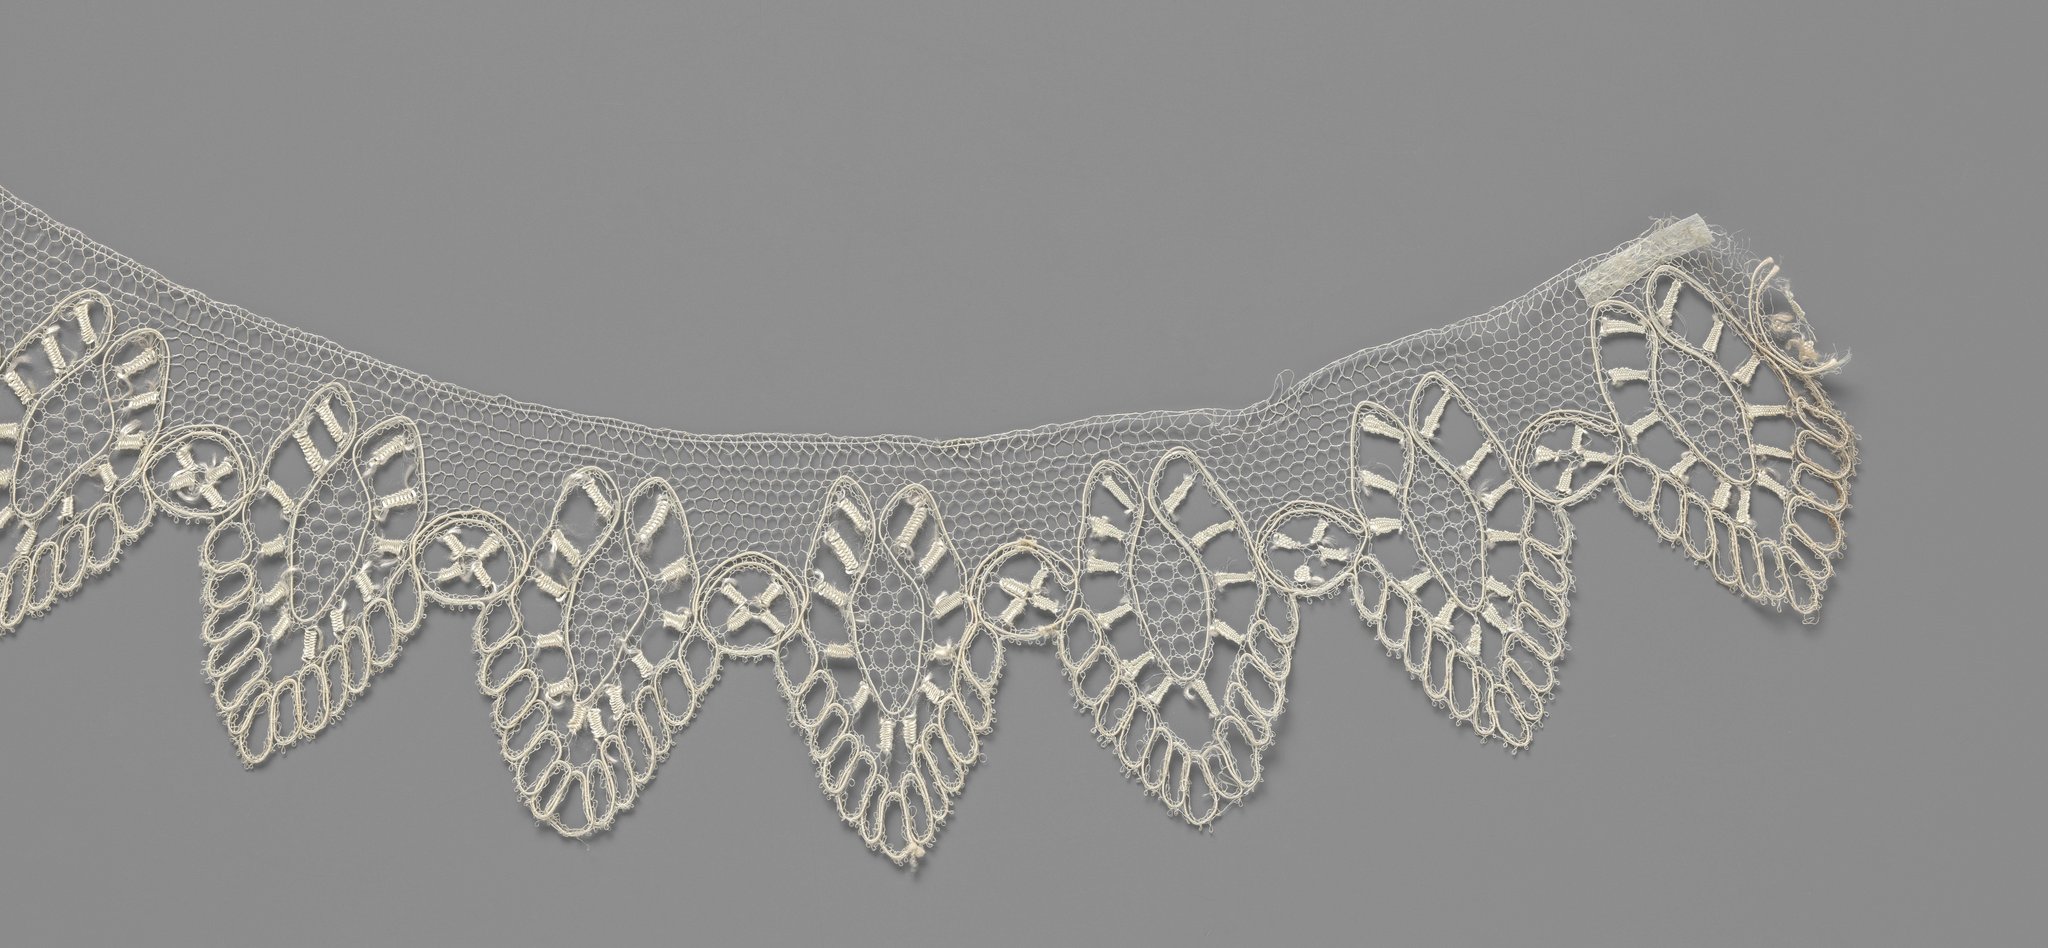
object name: strip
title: Strook kloskant met ovalen die diepe puntige schulpen vormen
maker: Anonymous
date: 1825-1849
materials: silk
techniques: lace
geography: france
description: Strook naturelkleurige kloskant: blonde. De kleur neigt vaag naar blauw. Het zich herhalende patroon bestaat uit een ovaal met één spitse punt, die naar beneden hangt en een diepe schulp vormt. De opeenvolgende schulpen zijn met elkaar verbonden door een opengewerkte cirkel, waarin een x-vormig motief is gemaakt in vormslag. De ovalen zijn gevormd door een siergrond, een rozengrond, waar een brede opengewerkte baan omheen loopt van contourdraden waartussen blokjes staan die zijn gemaakt in vormslag. Om het onderste gedeelte van de ovalen loopt nog een extra sierband, die wordt gevormd door een aaneenschakeling van opengewerkte en met fijne picots afgewerkte ovalen. De contourdraden bestaan uit een combinatie van een bundel flosdraden en een getwijnde draad. Aan de bovenkant zijn de motieven met elkaar verbonden door een traliegrond, een tulegrond. De bovenzijde is recht afgewerkt.